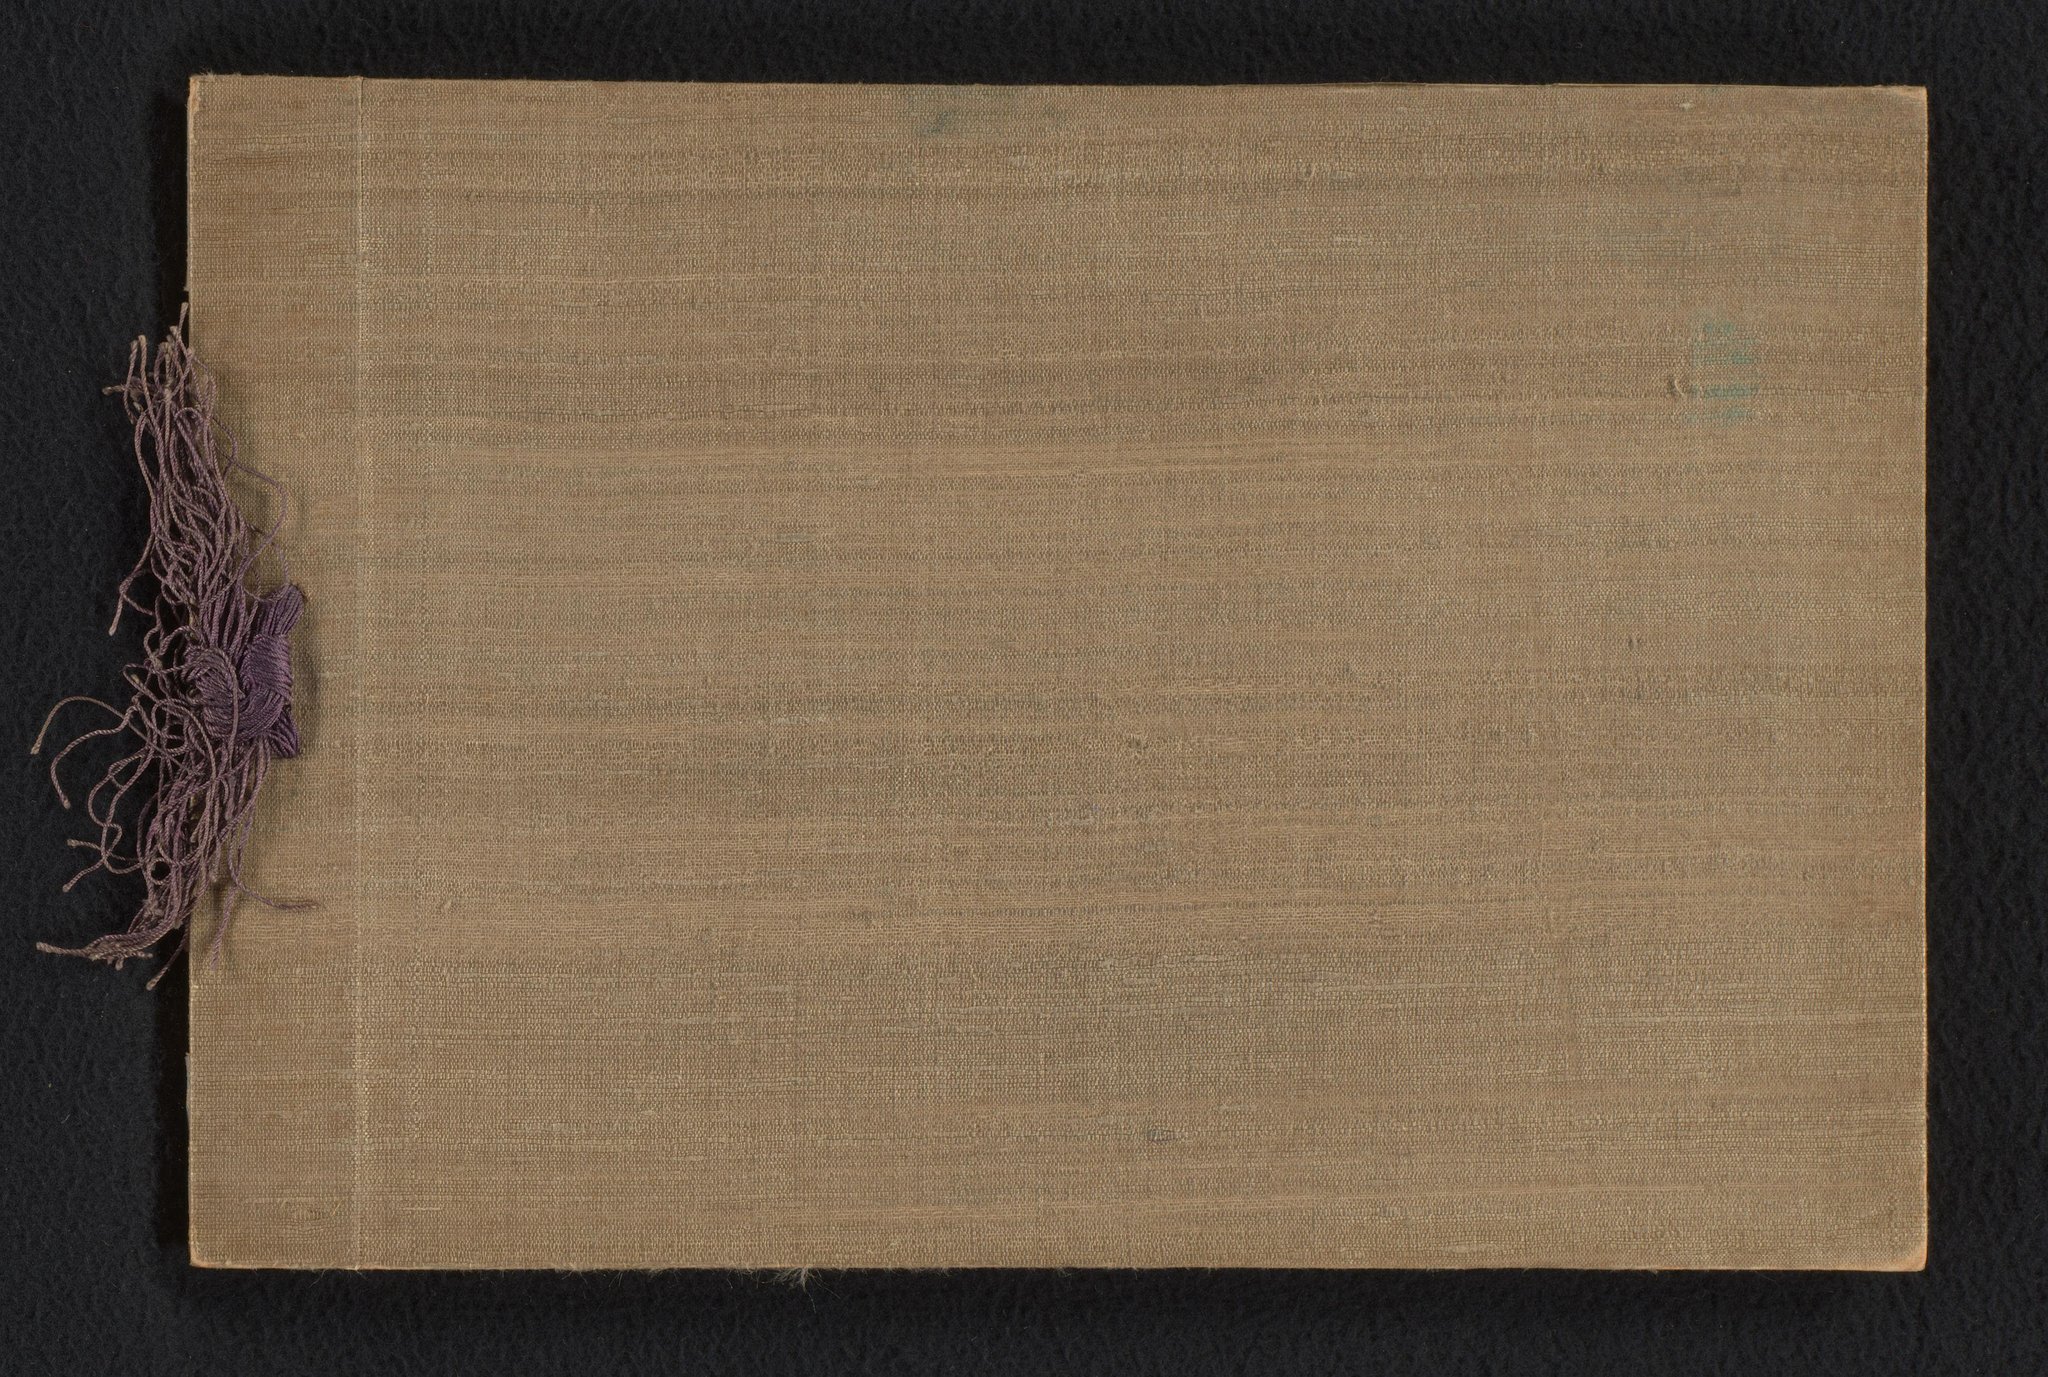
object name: book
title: Boek met 24 afbeeldingen van taferelen uit Japan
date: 1890-1910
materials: linen, paper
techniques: photograph, hand coloring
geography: yokohama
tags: children's games and plays, historical persons, bicycle, folk costume, regional costume, fisherman, japan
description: Boek met 24 ingekleurde lichtdrukken waarop diverse taferelen uit Japan zijn afgebeeld.